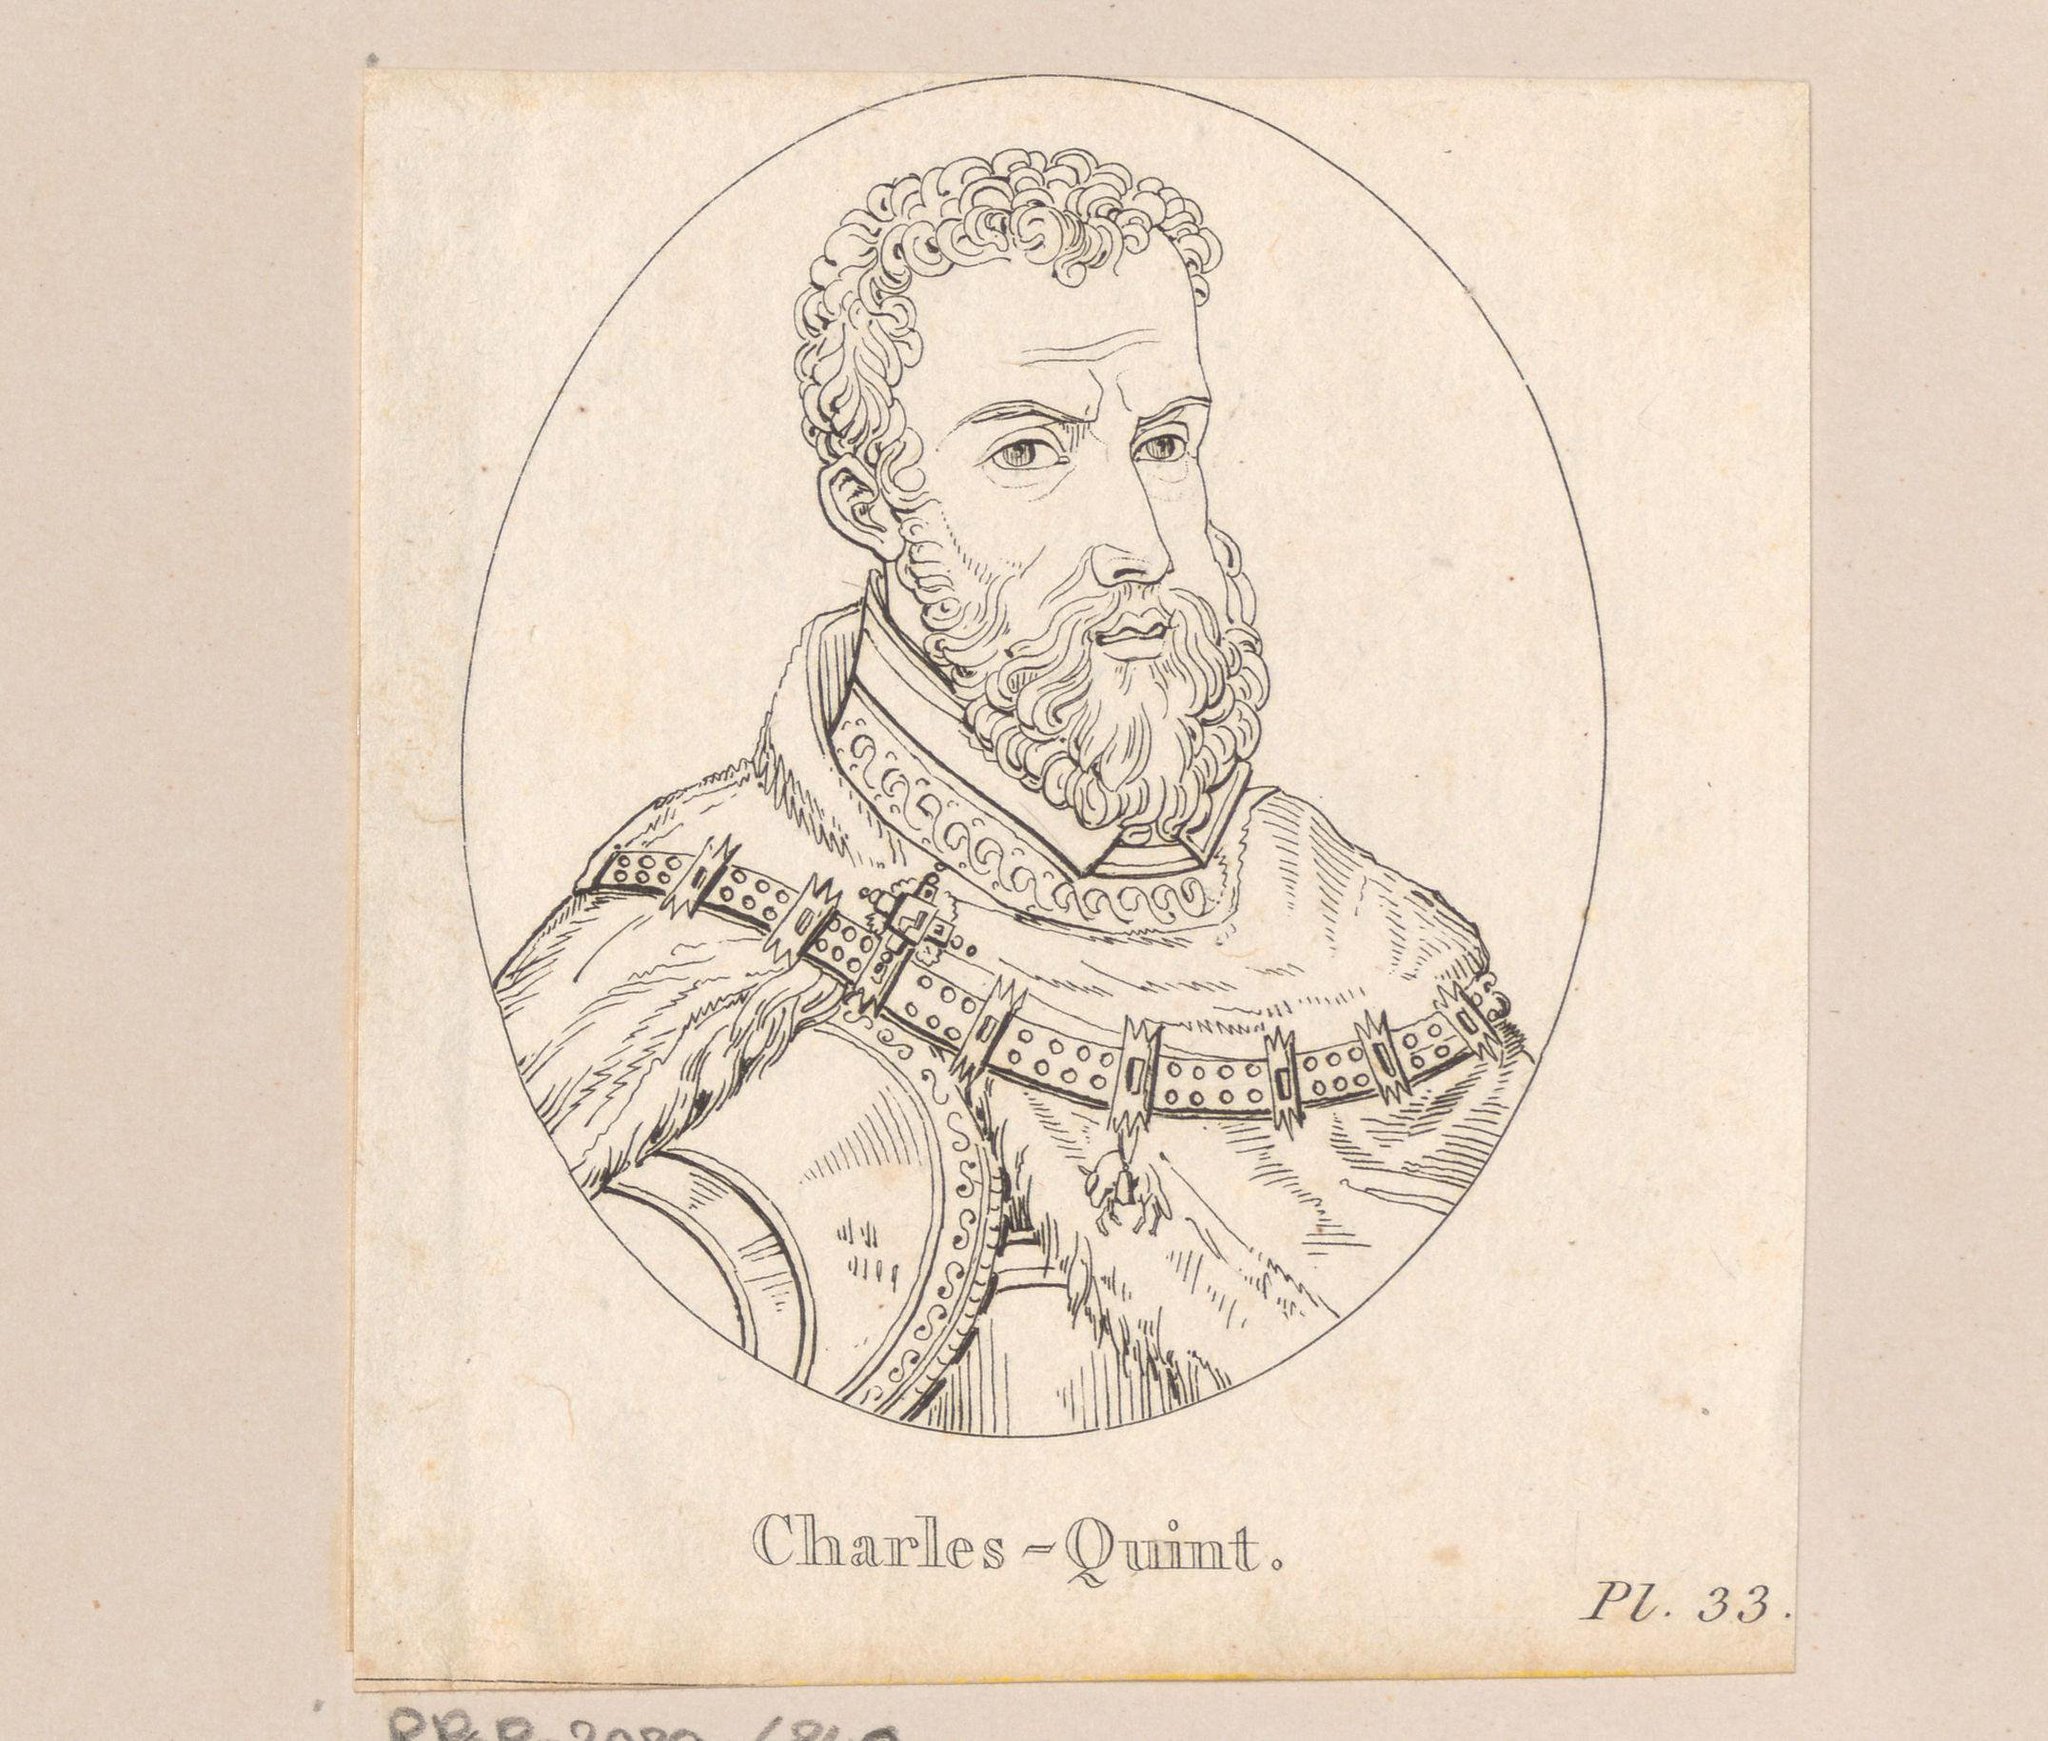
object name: print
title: Portret van keizer Karel V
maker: Anonymous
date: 1775-1824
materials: paper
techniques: etching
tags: ghent, charles v (holy roman emperor and king of spain), historical persons, knighthood order of the golden fleece, king